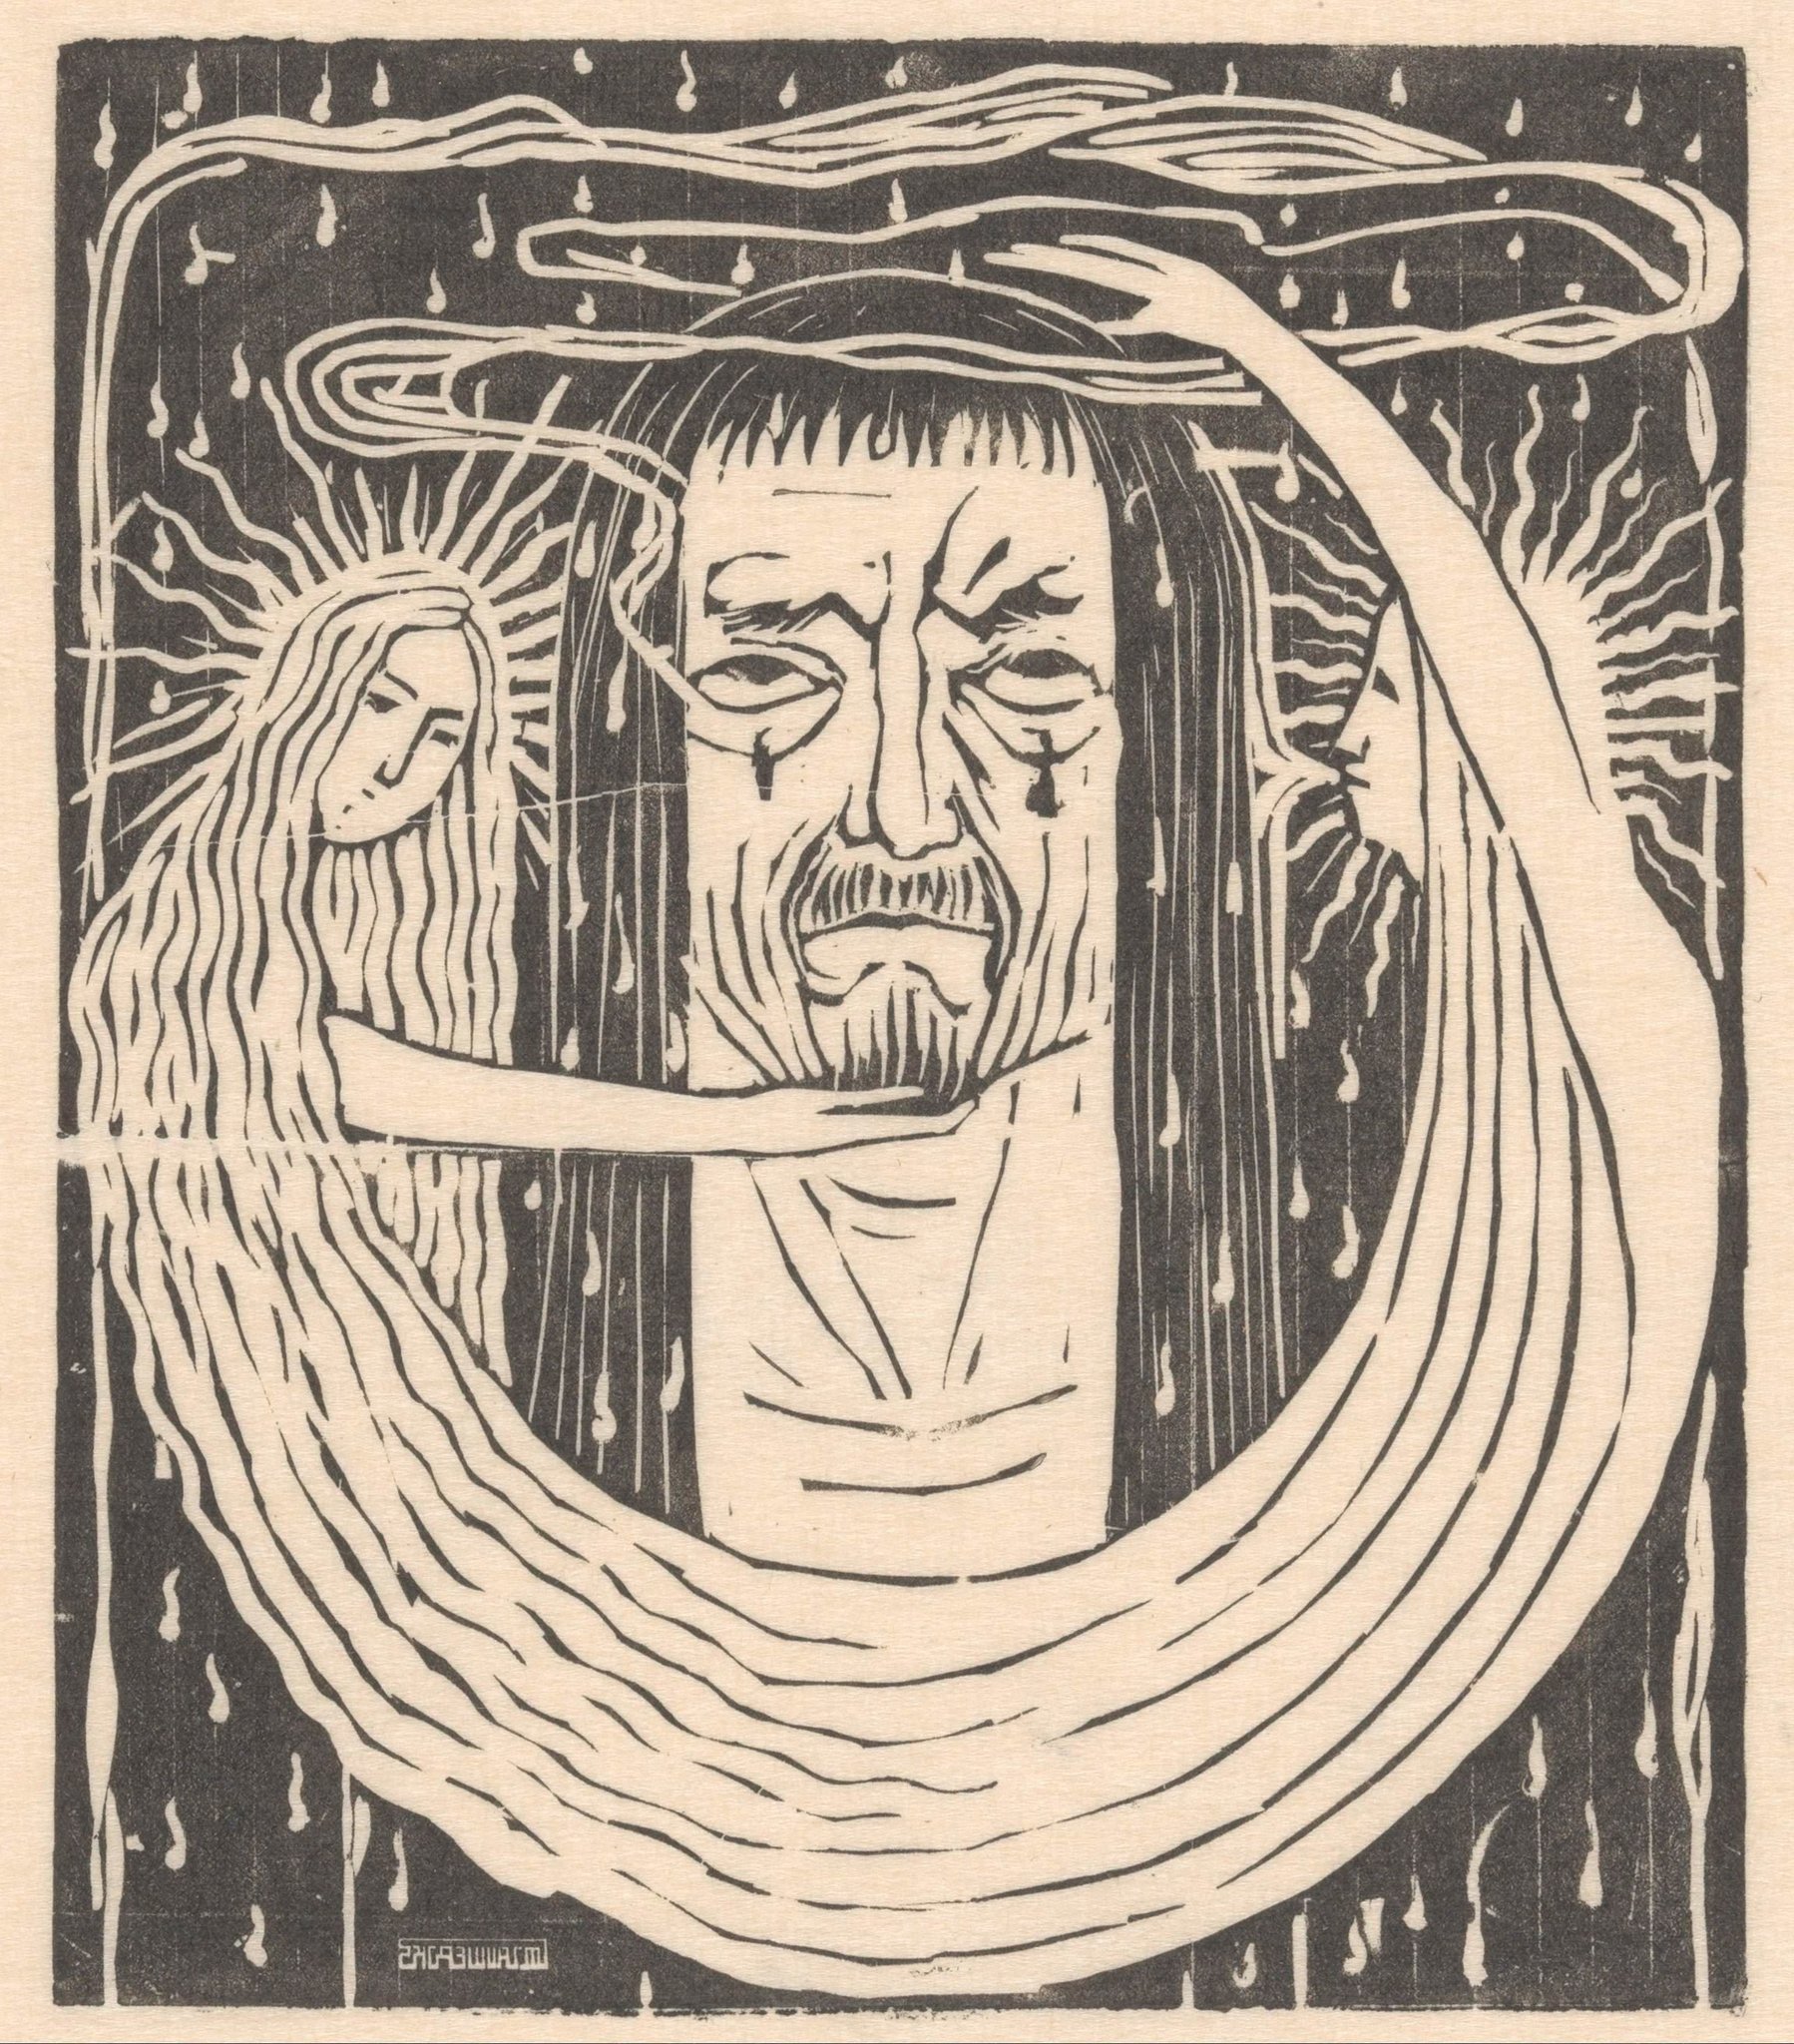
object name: print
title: Mannenhoofd en figuren in de regen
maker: mathieu lauweriks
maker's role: designer, draughtsman, print maker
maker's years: 1864-1932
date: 1894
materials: paper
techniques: woodcut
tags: head (human), twins, rain, mist, fog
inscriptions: collector's mark: Lugt 2228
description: In het midden het hoofd van een man in de regen. Boven hem mistslierten. Aan weerszijden wordt zijn hoofd aangeraakt door een vrouwelijk figuur met stralen rond het hoofd. De twee vrouwelijke figuren zijn aan elkaar verbonden met een boog van haar.